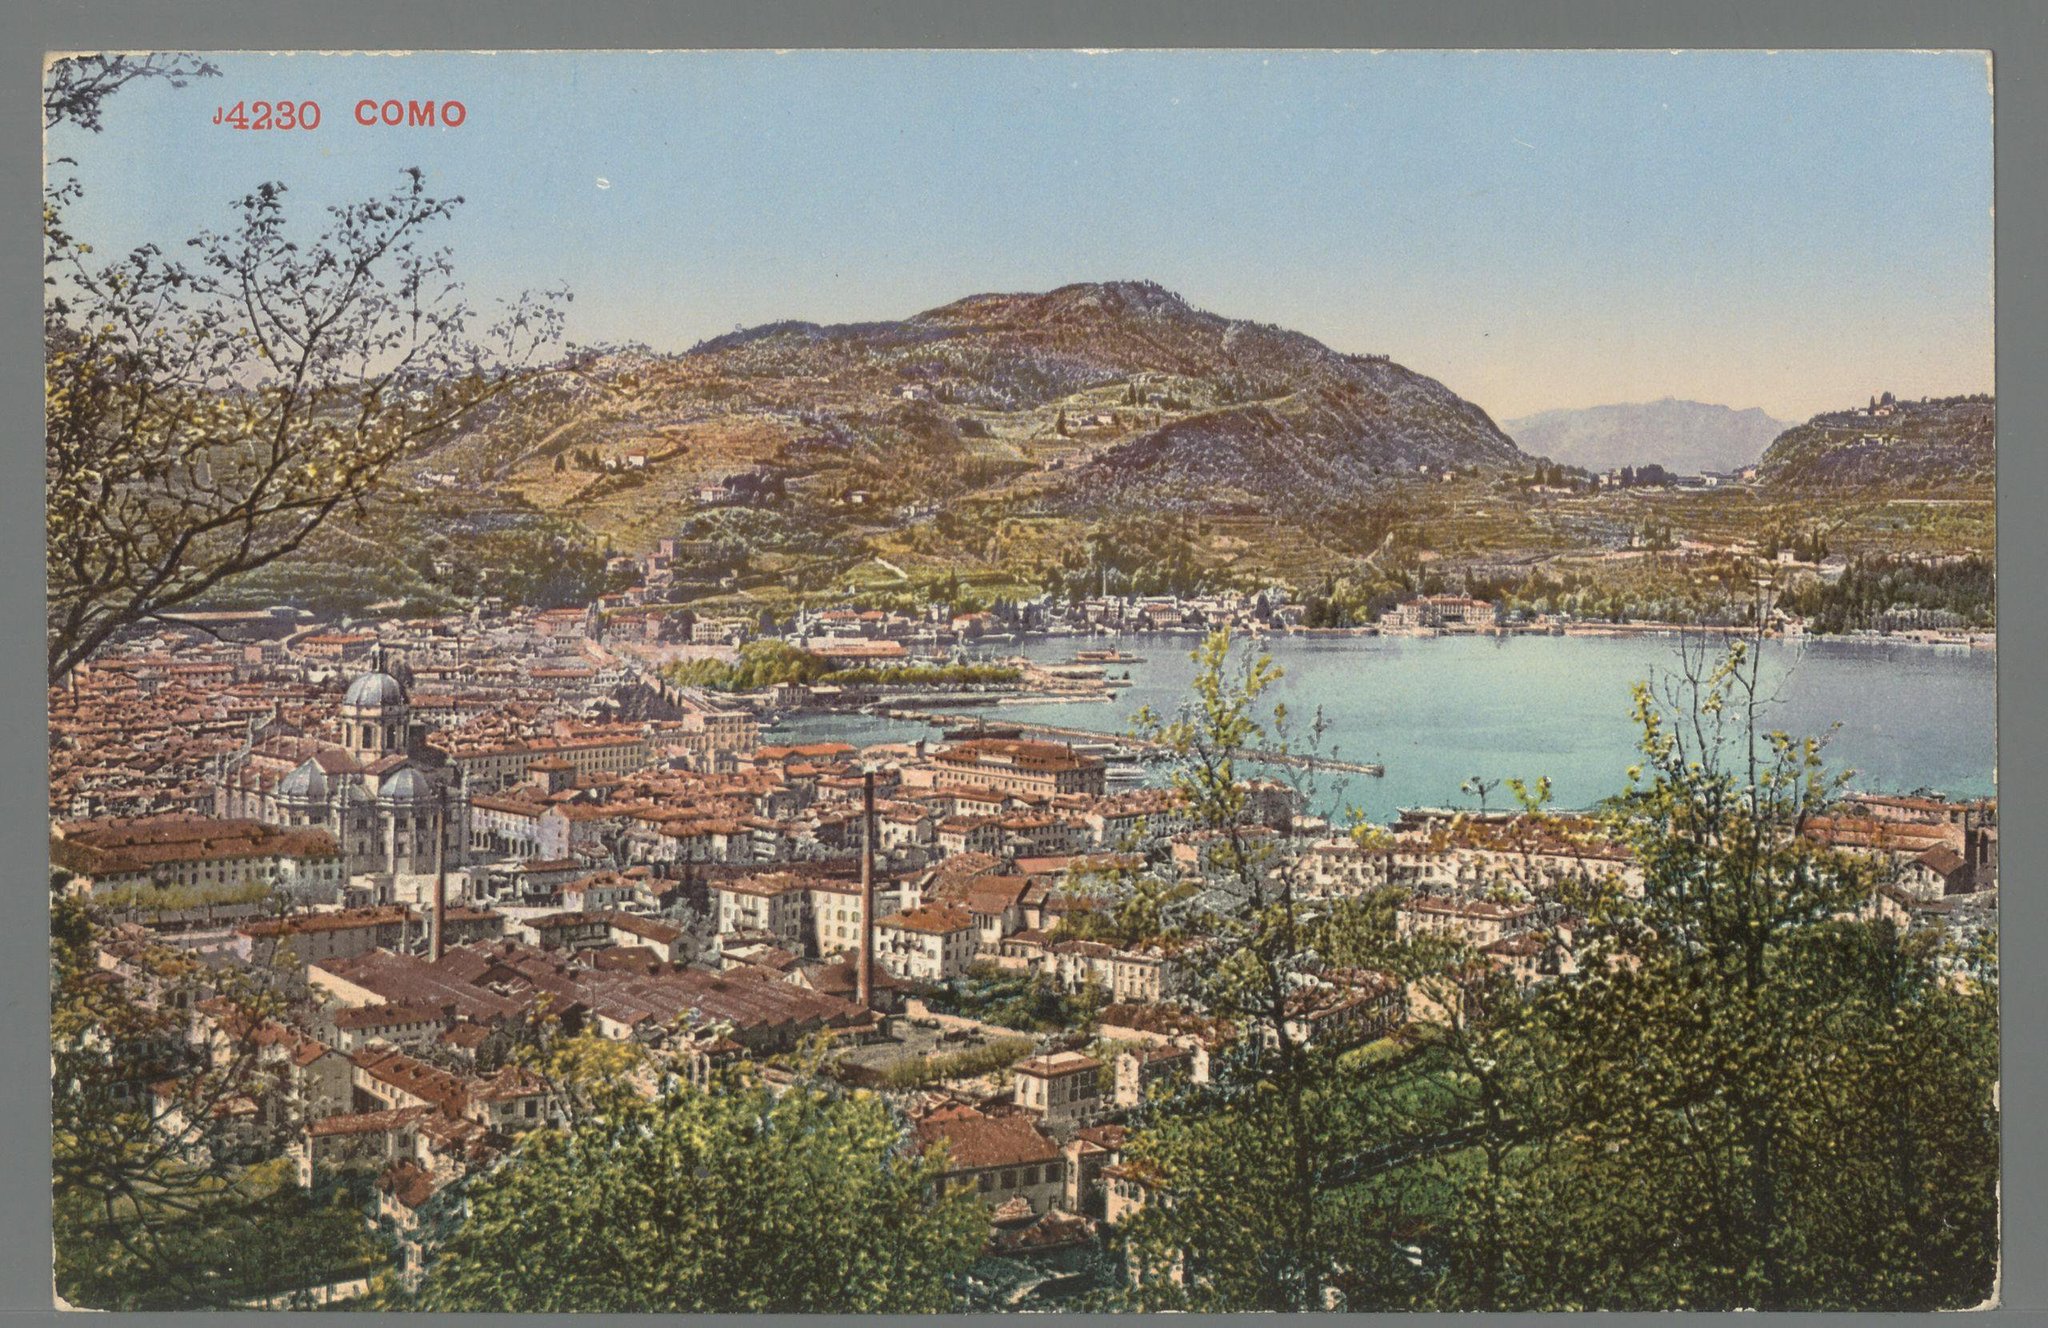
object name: ansichtkaart, prentbriefkaart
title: Como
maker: Anonymous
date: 1905-1930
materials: cardboard, photographic process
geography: como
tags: landscapes in the temperate zone, lake, prospect of city, town panorama, silhouette of city